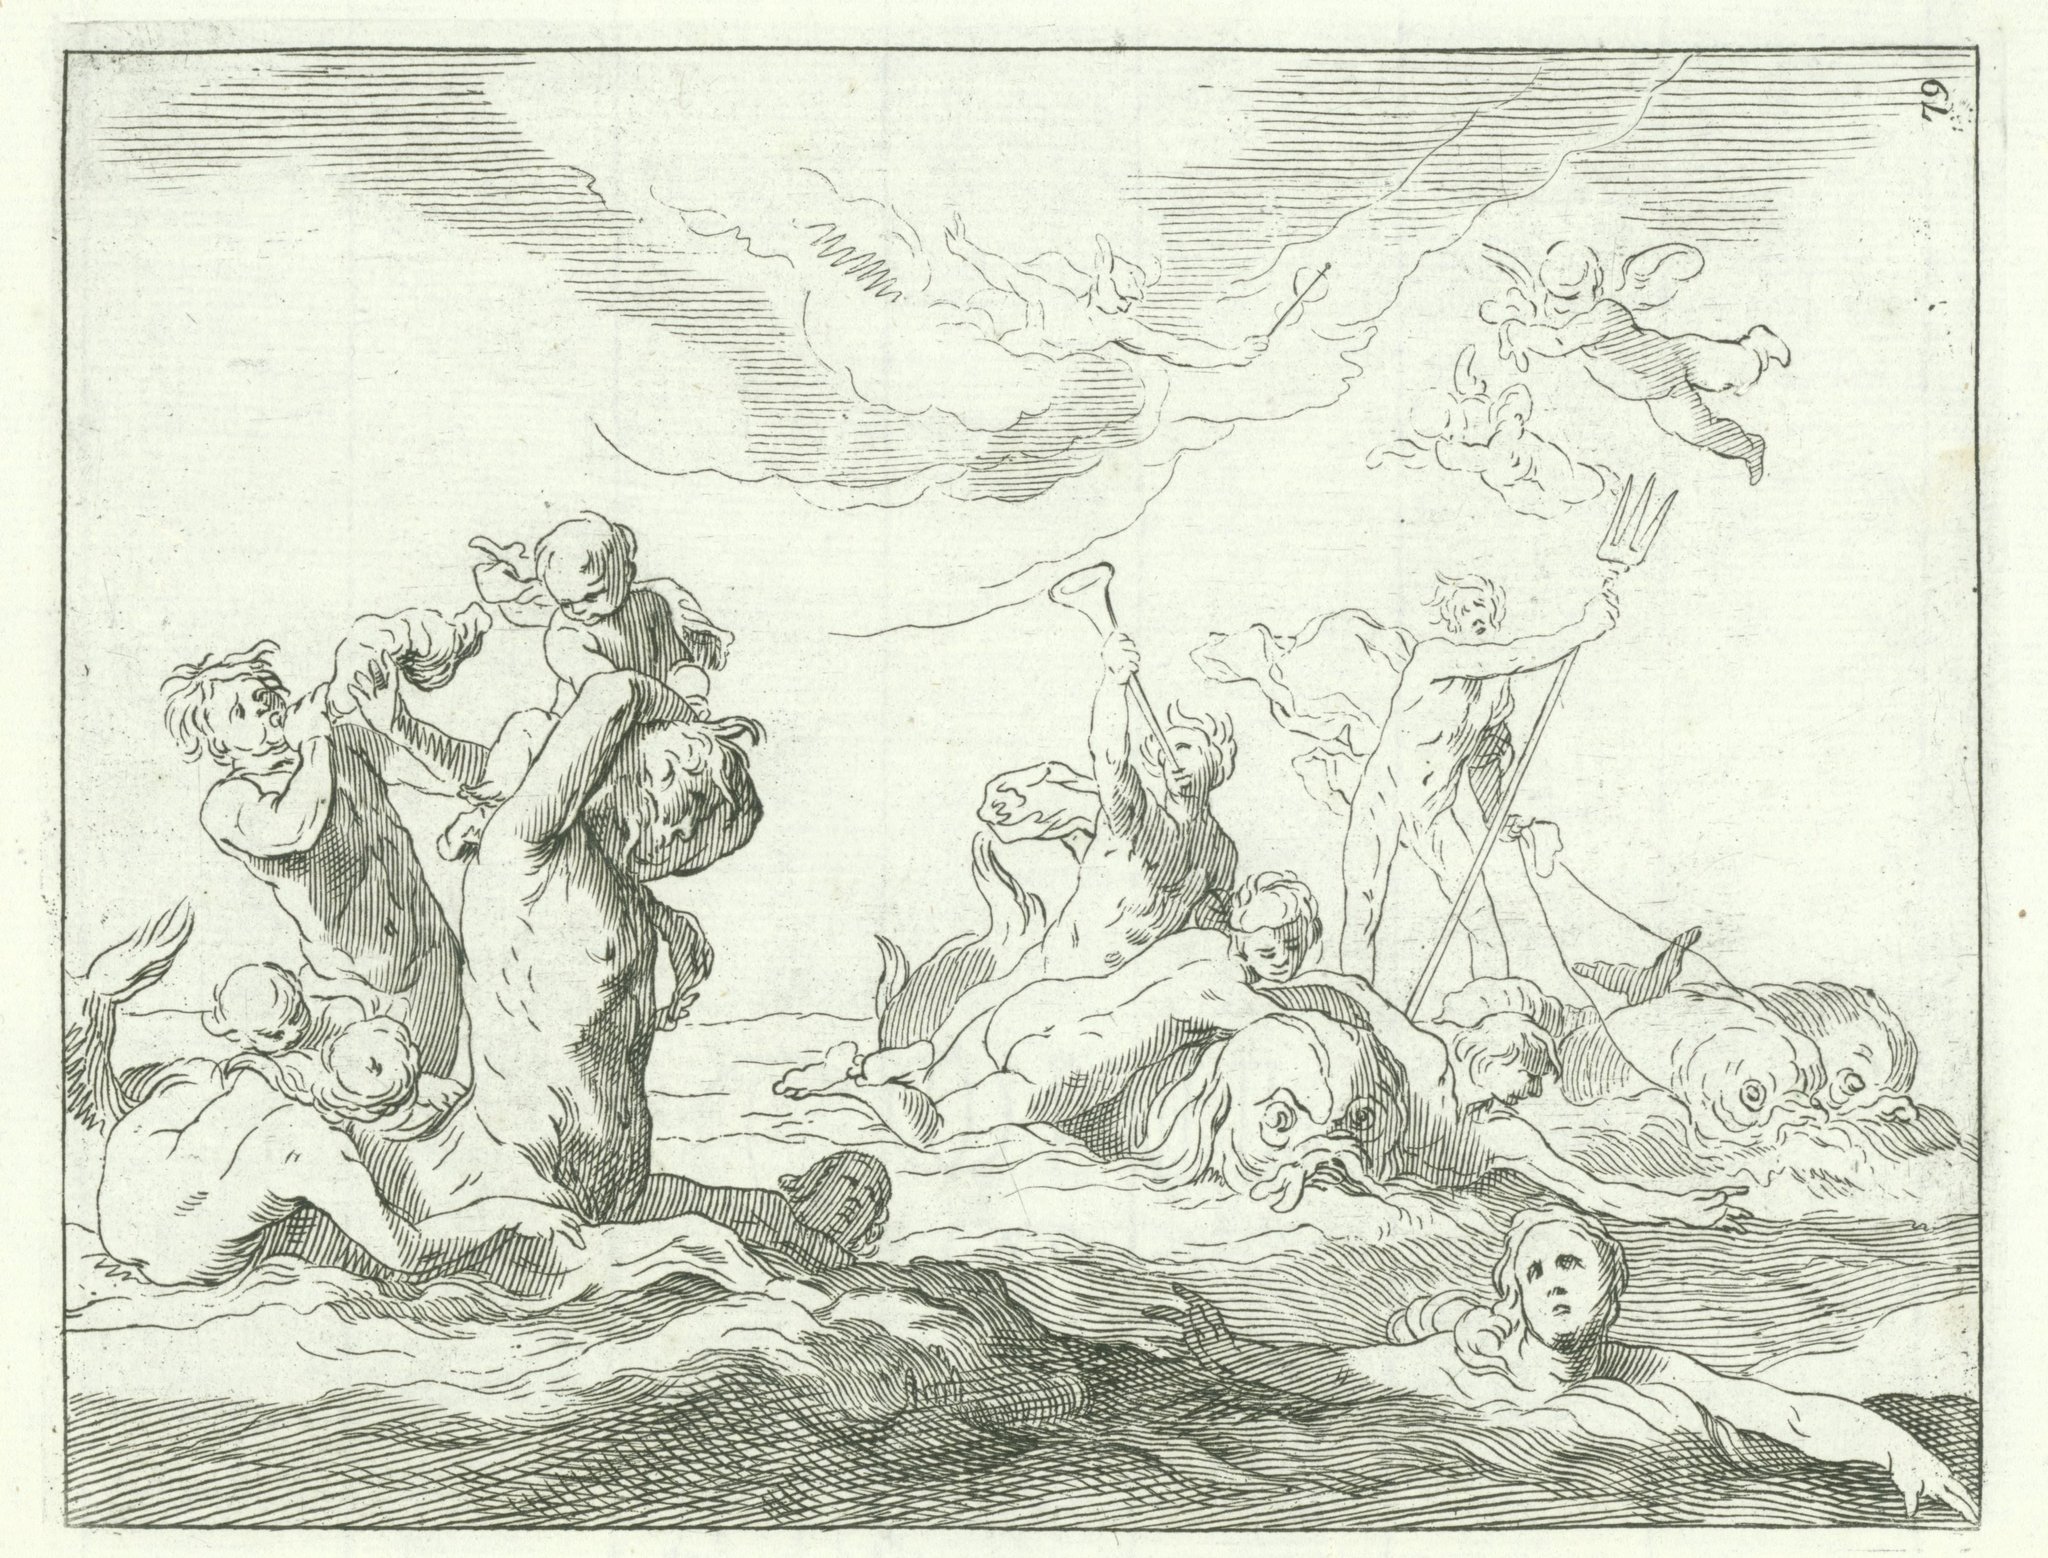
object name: print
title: Groot Teekenboek...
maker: willem van vliet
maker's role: publisher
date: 1820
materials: paper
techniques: etching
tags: (story of) neptune (poseidon)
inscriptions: number: ‘79’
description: No. 79 in Groot Teekenboek. Neptunus met drietand, heerser over de zee, wordt hier door dolfijnen voortgetrokken. De dolfijnen die de nereïde Amphritite achtervolgden toen zij gevlucht was voor Neptunus’ toenaderingen, hebben haar overreden om terug te komen en zijn bruid te worden. Hier rijdt zij naast Neptunus op de rug van een dolfijn. Neptunus en Amphritite worden omringd door zeenimfen en tritons. Boven hen zweven putti.